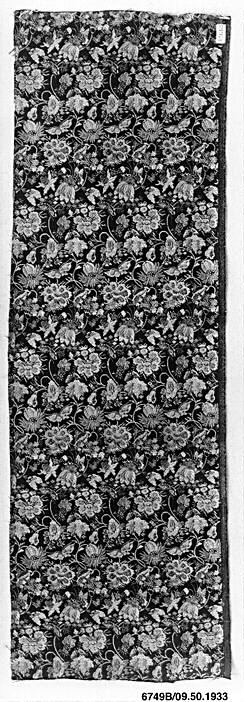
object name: piece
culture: japanese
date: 1801-1900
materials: silk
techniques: brocade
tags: leaves